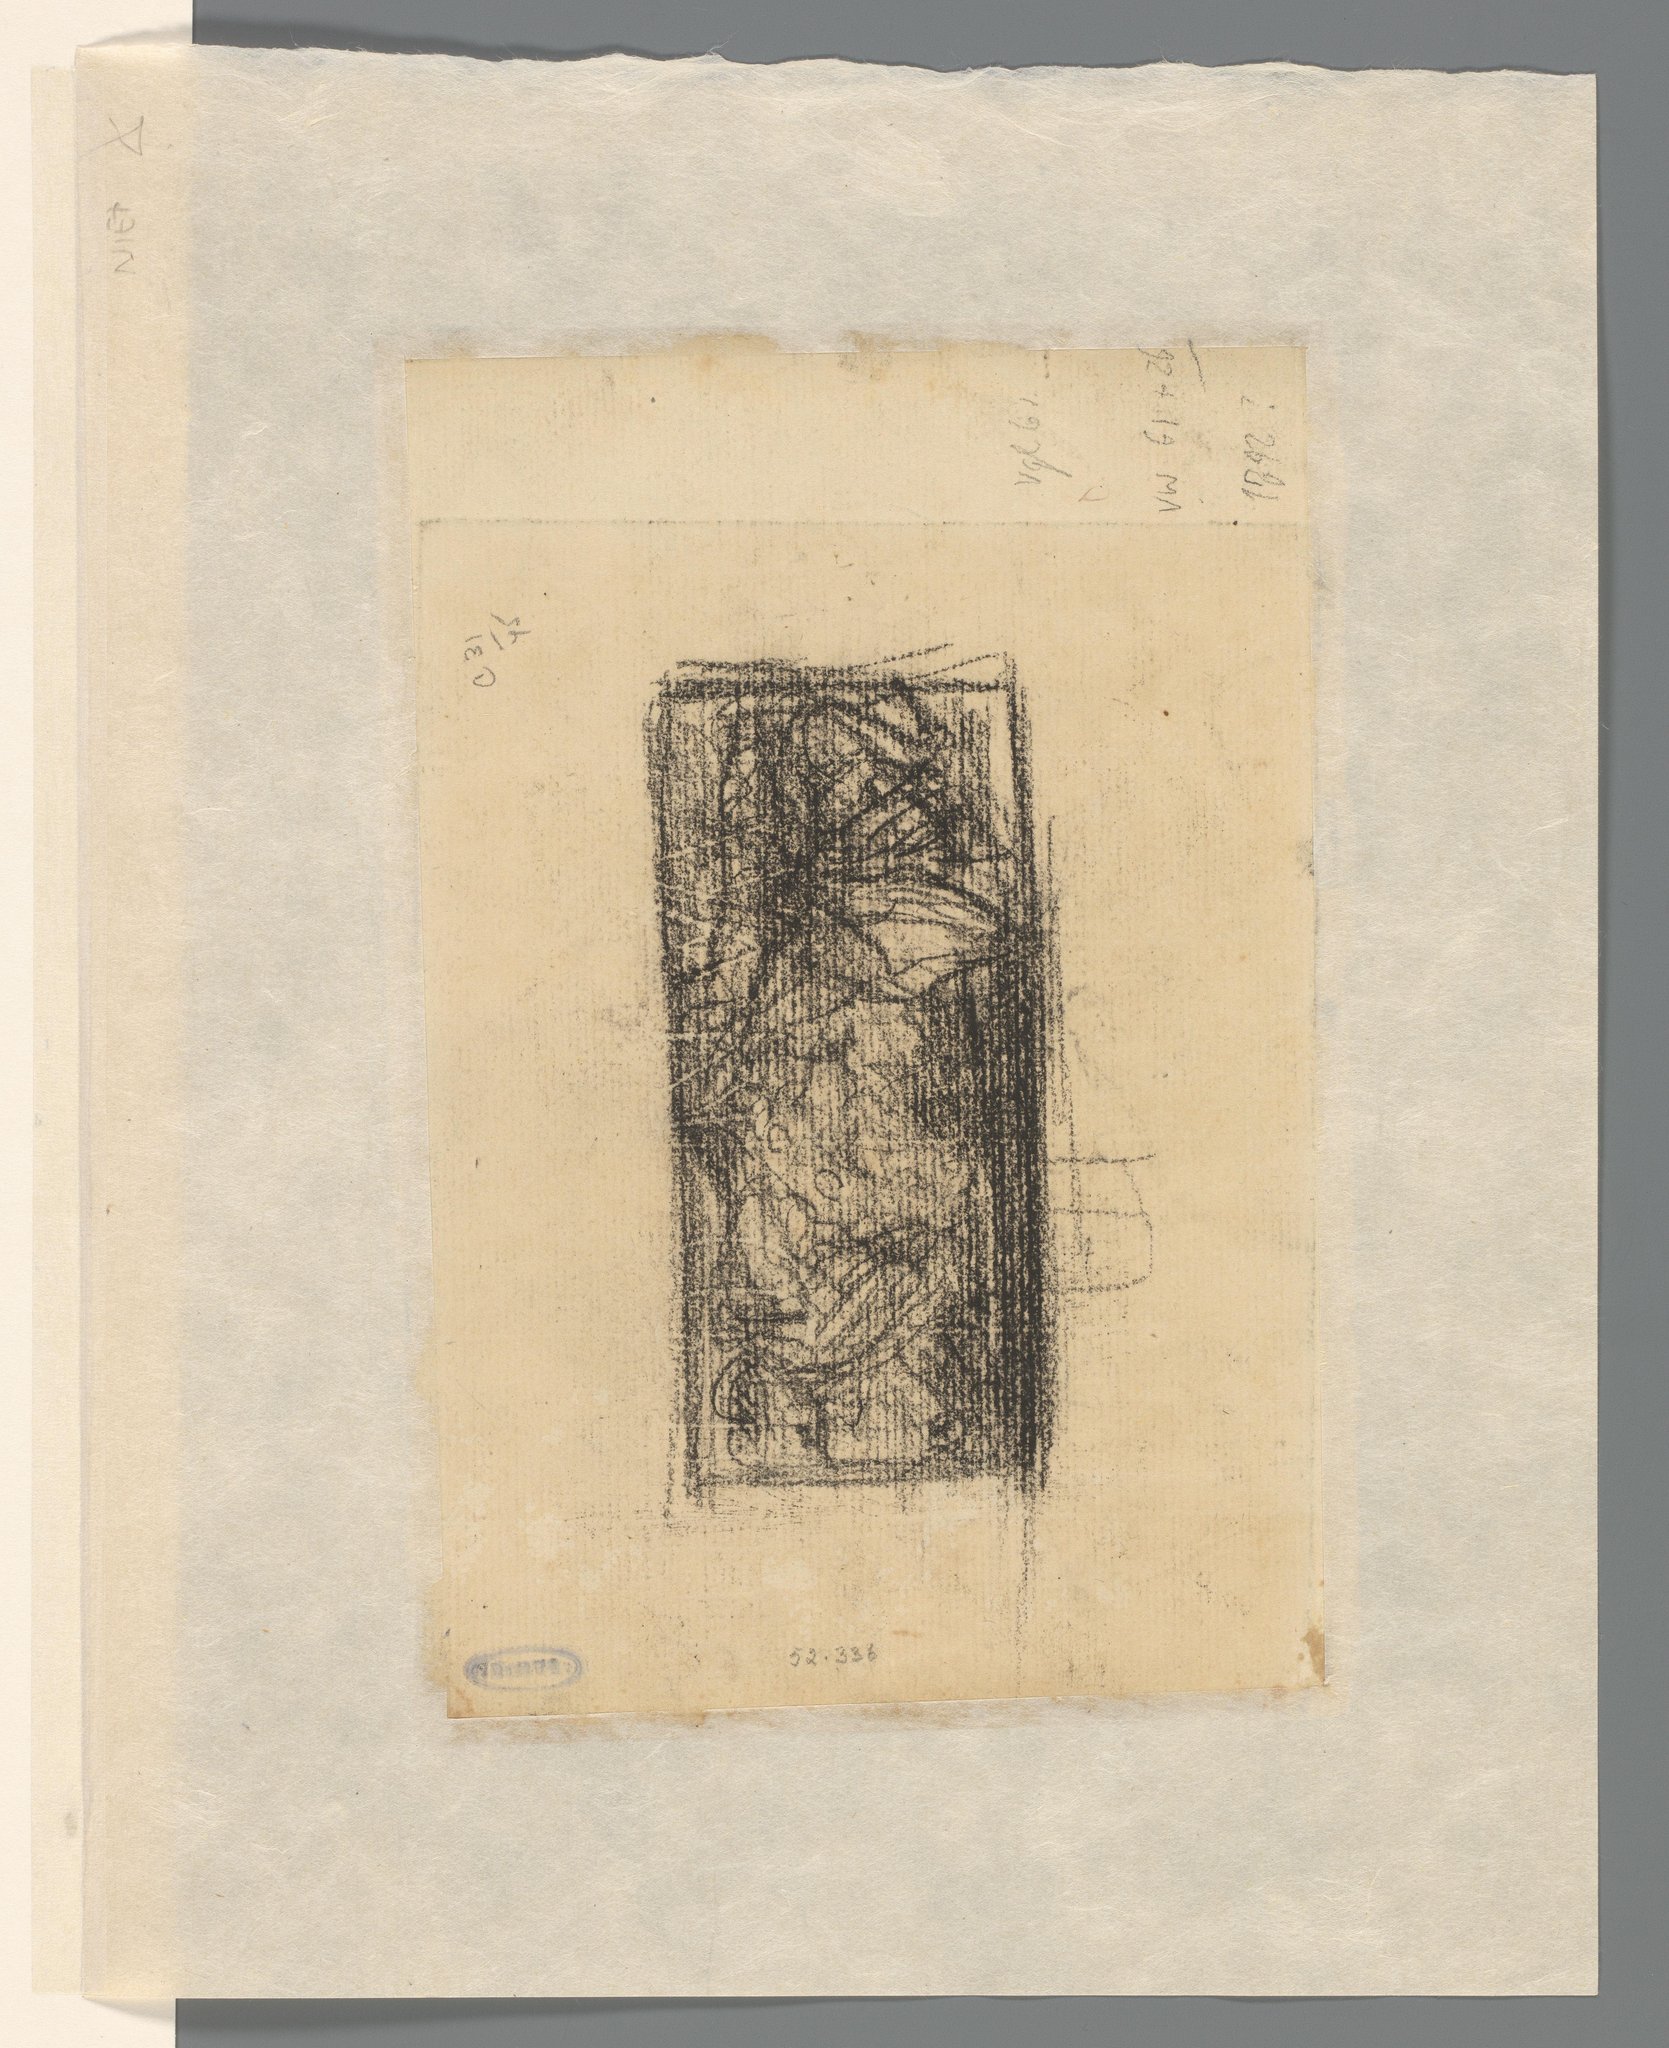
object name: drawing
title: Mensenmenigte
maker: marius bauer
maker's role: draughtsman, print maker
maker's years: 1867-1932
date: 1877-1932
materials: chalk, paper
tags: crowd, mob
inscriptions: collector's mark: Lugt 2228